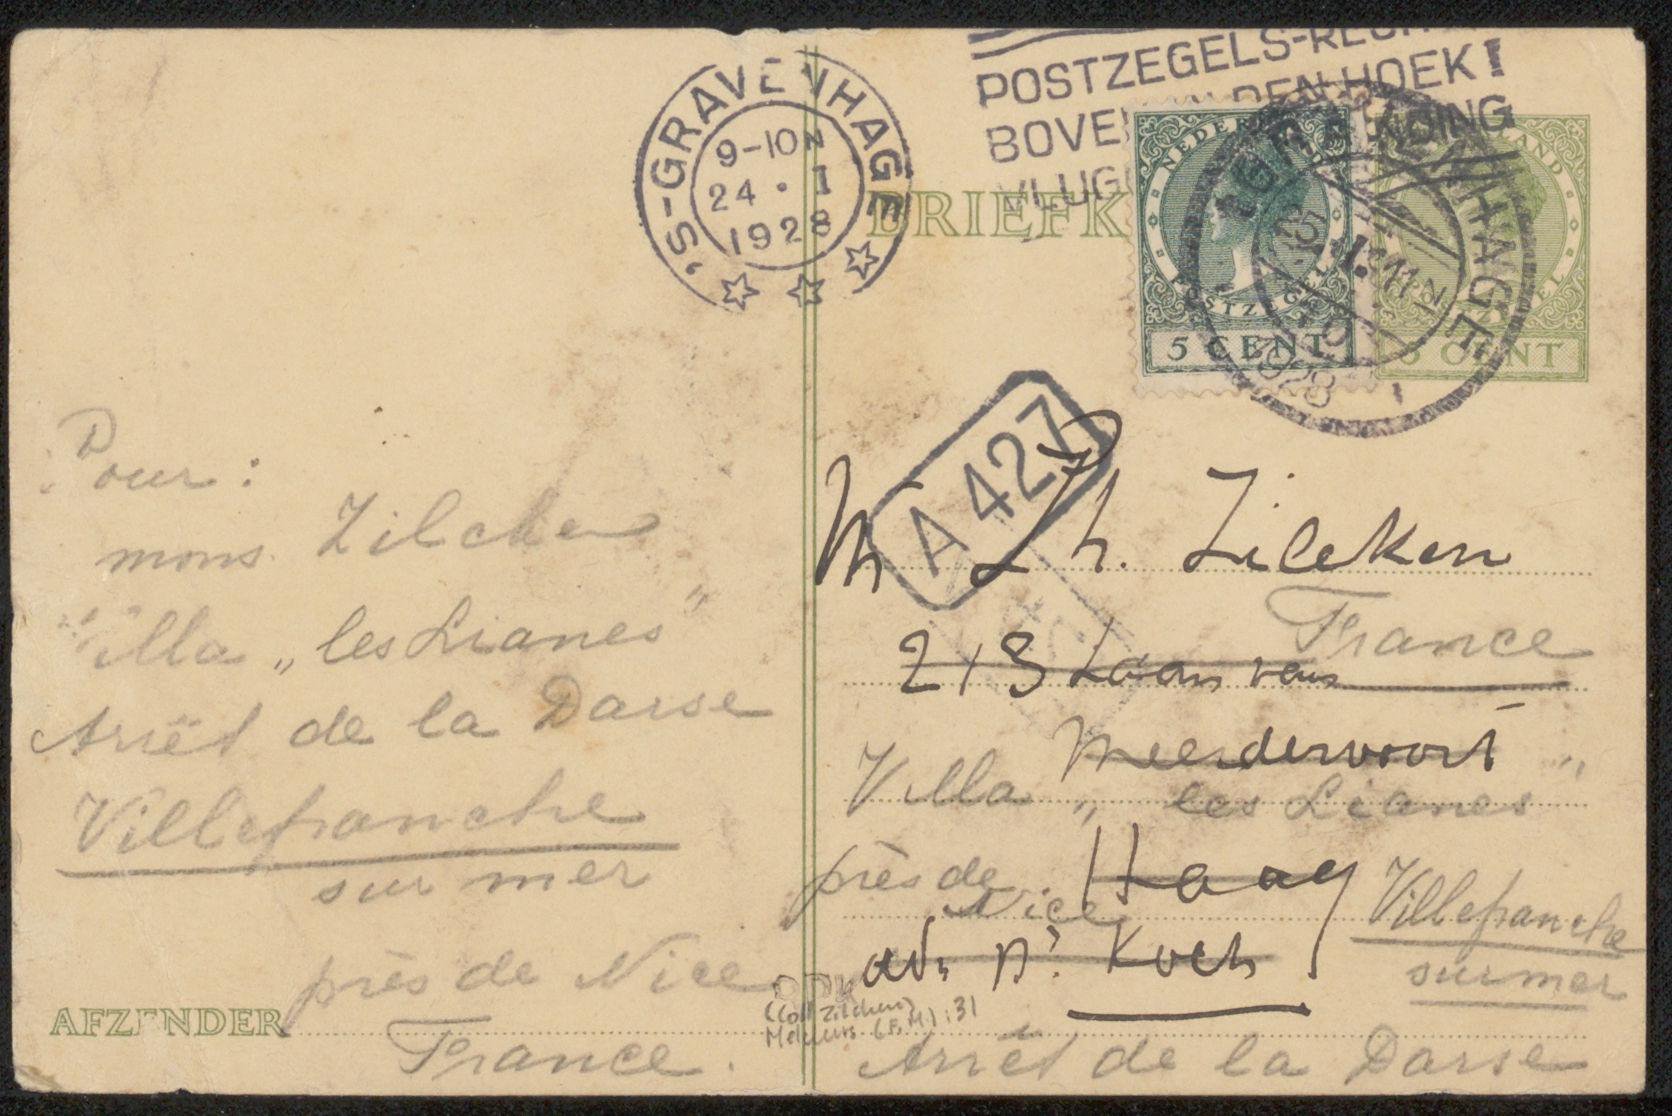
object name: postcard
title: Briefkaart aan Philip Zilcken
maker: franz melchers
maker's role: draughtsman, painter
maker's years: 1868-1944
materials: cardboard, ink, pencil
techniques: pen, writing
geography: the hague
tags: the hague, philip zilcken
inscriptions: collector's mark: ‘RPK’